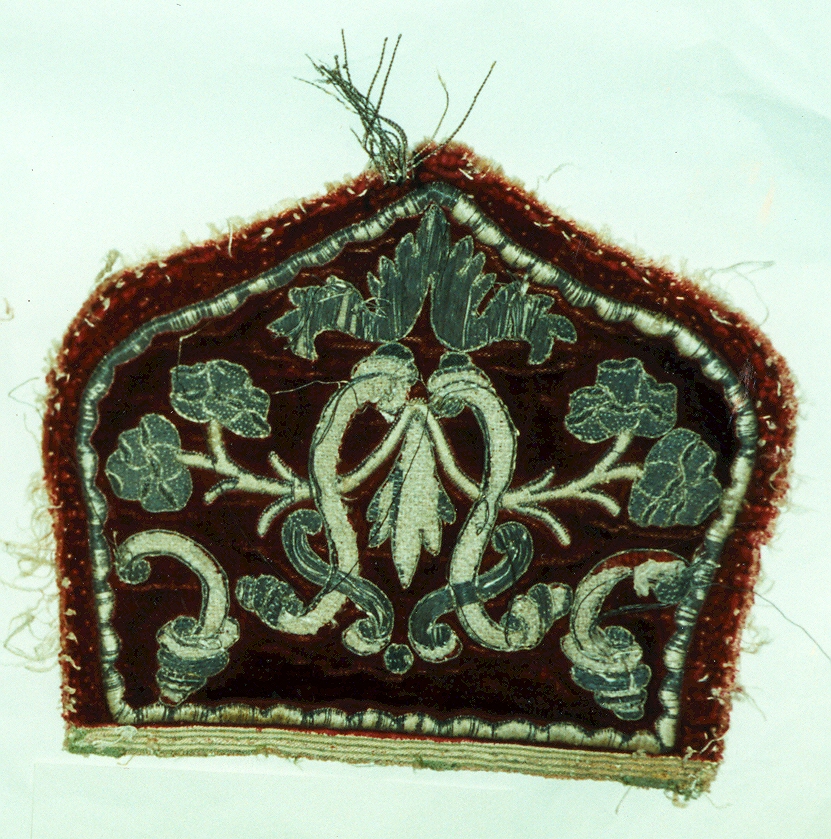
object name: pocket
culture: italian or spanish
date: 1701-1800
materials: metal, silk